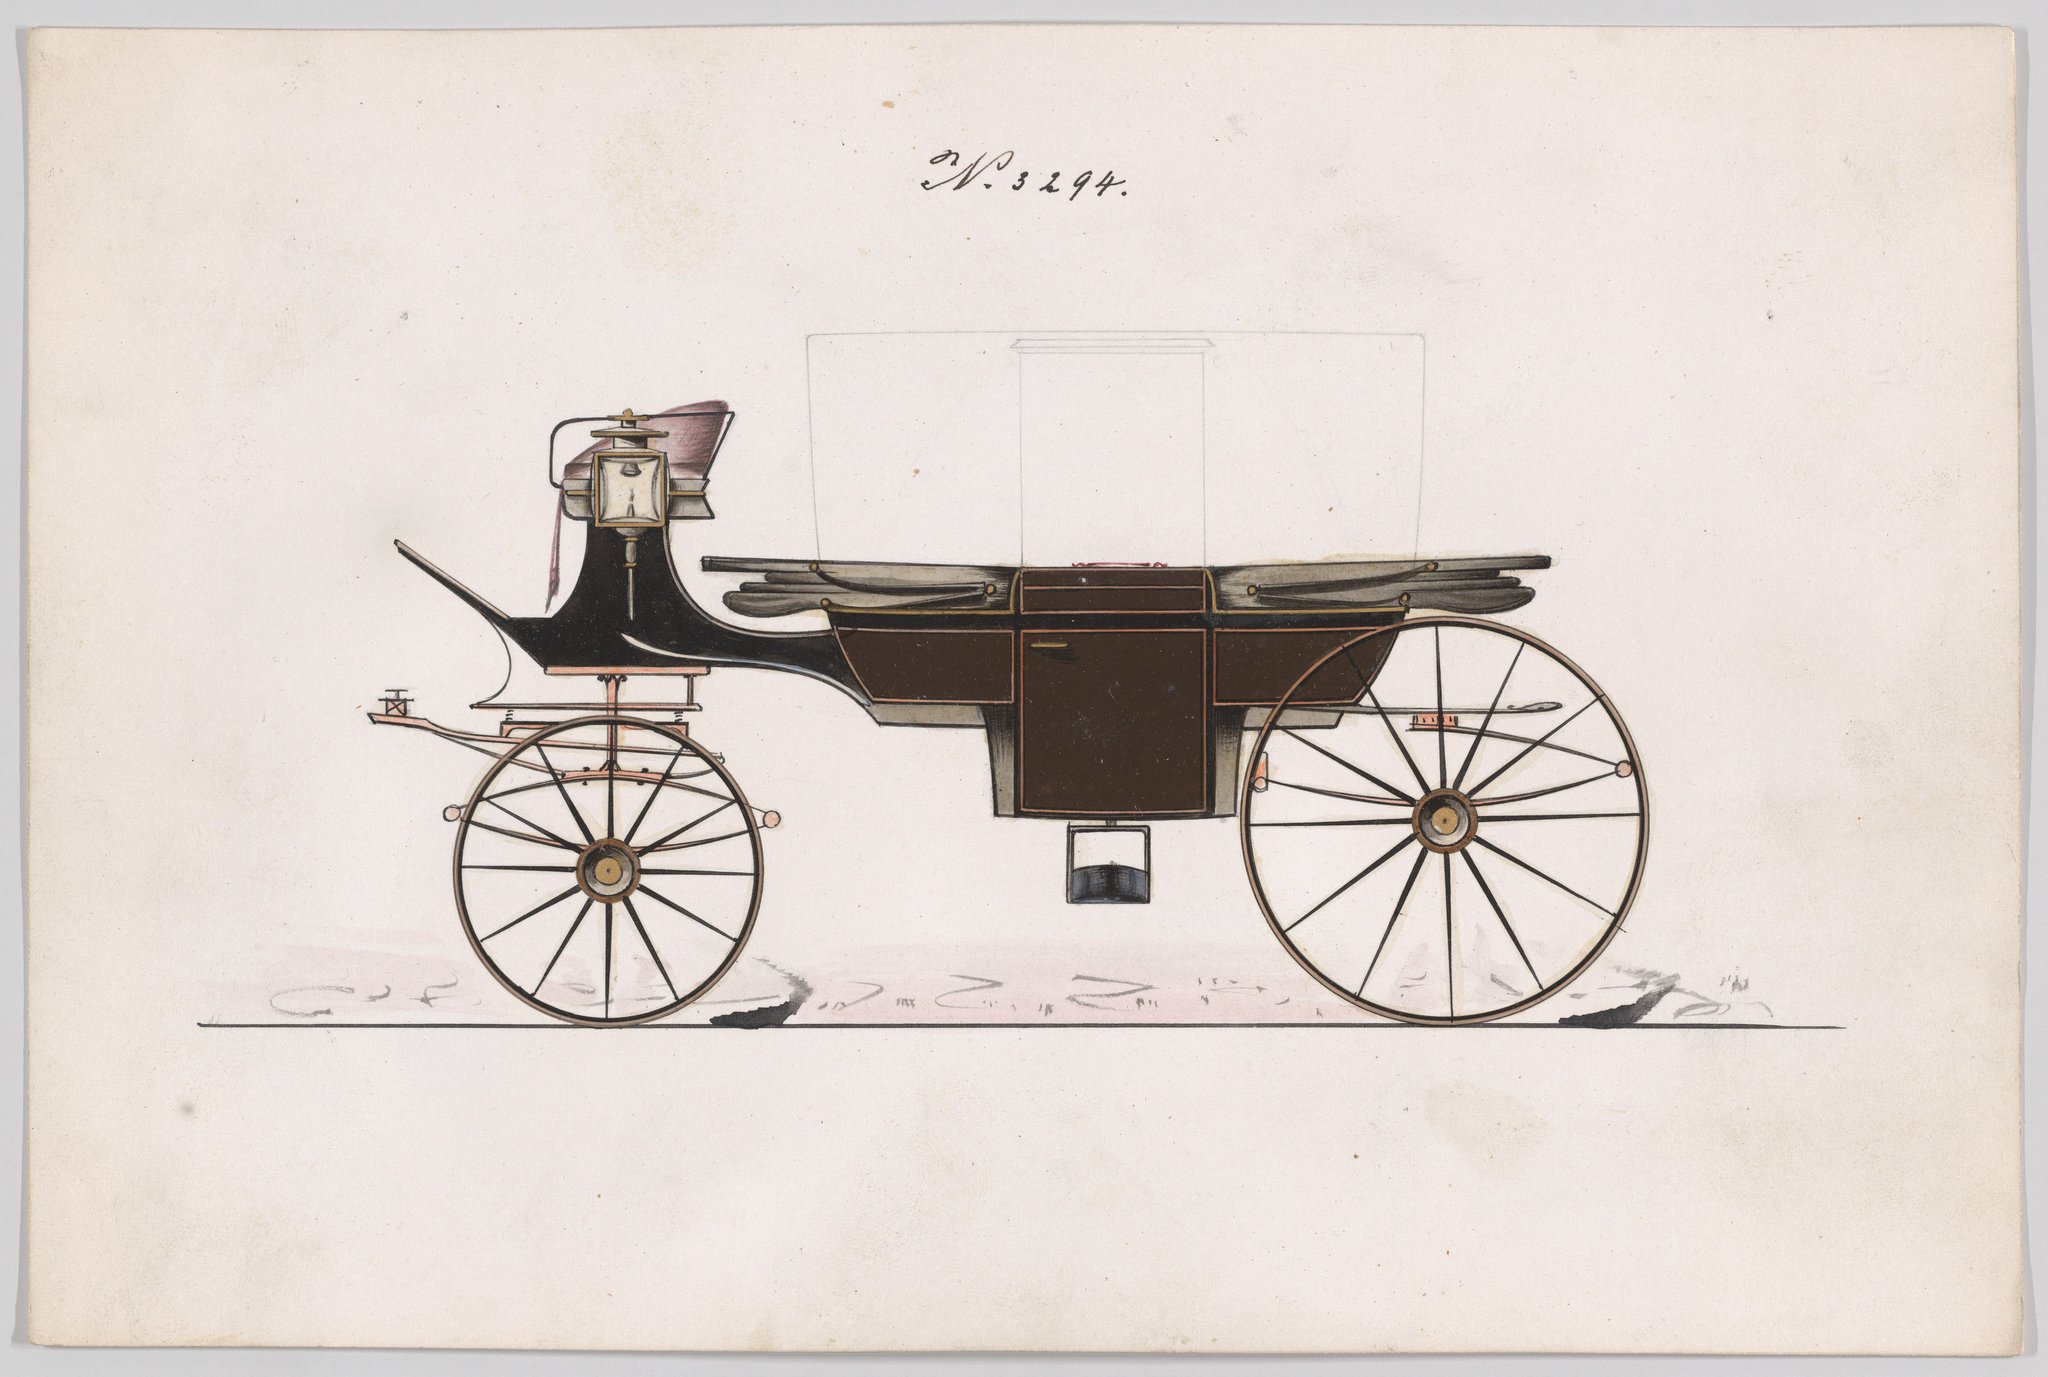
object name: drawing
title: Landau #3294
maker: brewster & co.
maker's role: manufacturer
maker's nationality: american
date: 1877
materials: gouache, graphite, gum arabic, ink, watercolor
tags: carriages